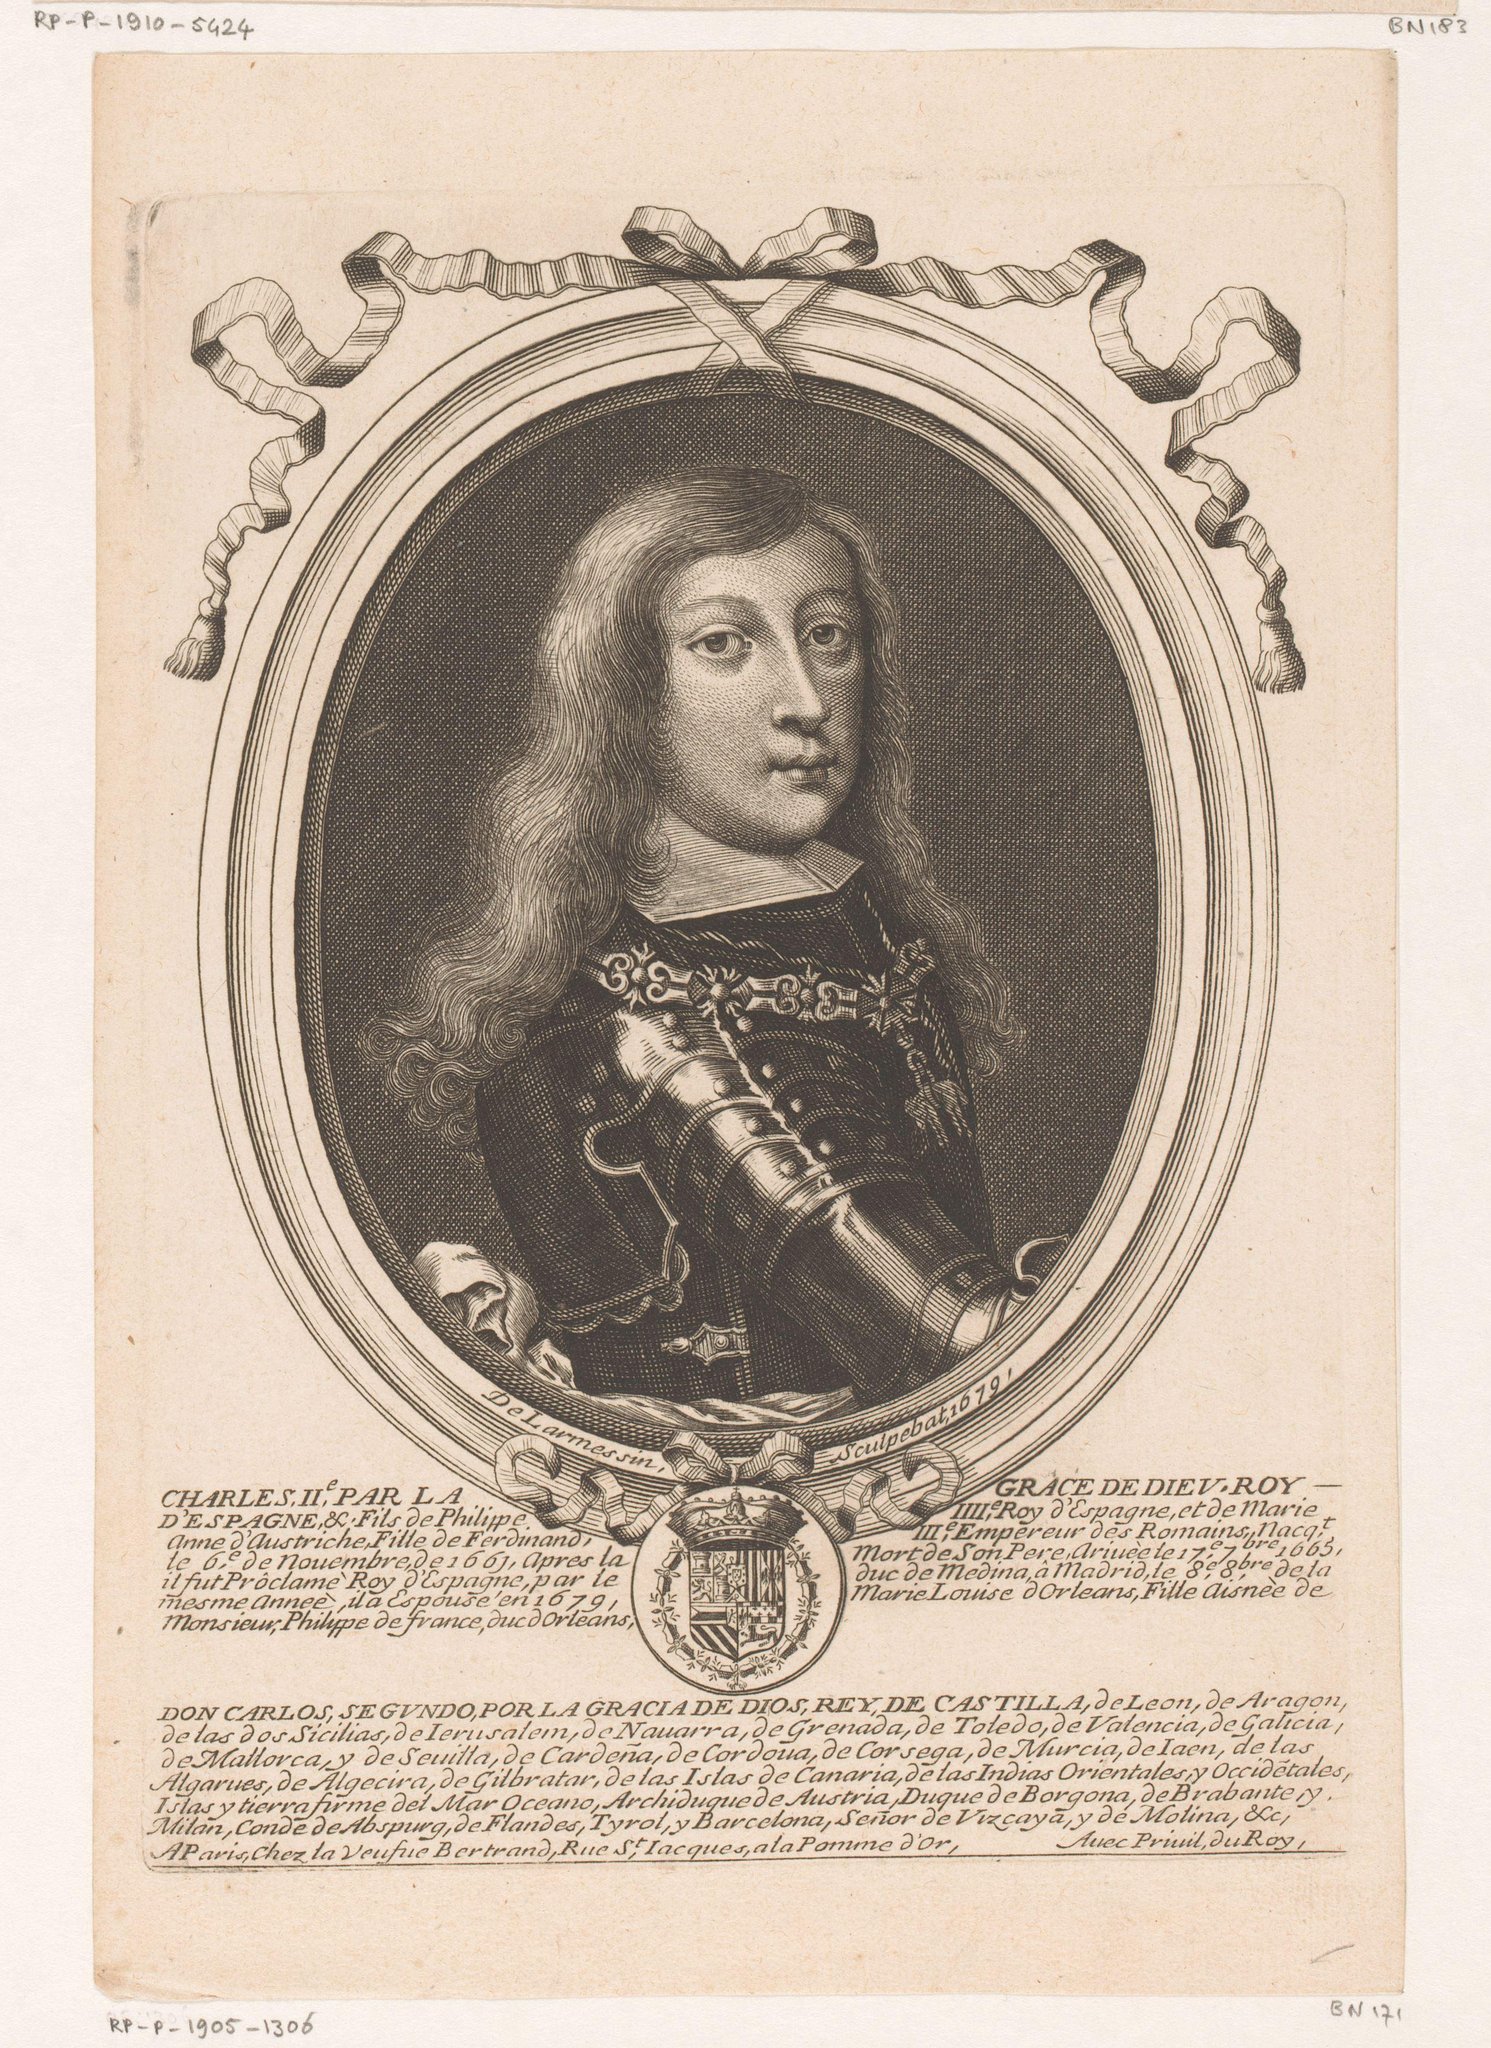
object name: print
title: Portretten van prominente figuren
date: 1679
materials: paper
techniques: engraving, etching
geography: paris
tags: karel ii (koning van spanje), historical persons, king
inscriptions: collector's mark: Lugt 2228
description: Maakt deel uit van een grootschalige serie met portretten van prominente figuren. Binnen de serie bevindt zich een sectie getiteld 'Les Augustes Représentations De tous les Roys De France depuis Pharamond Iusqu'à Louys XIIII'. De serie werd respectievelijk uitgegeven door Pierre Bertrand, door zijn weduwe en door De Larmessin zelf.